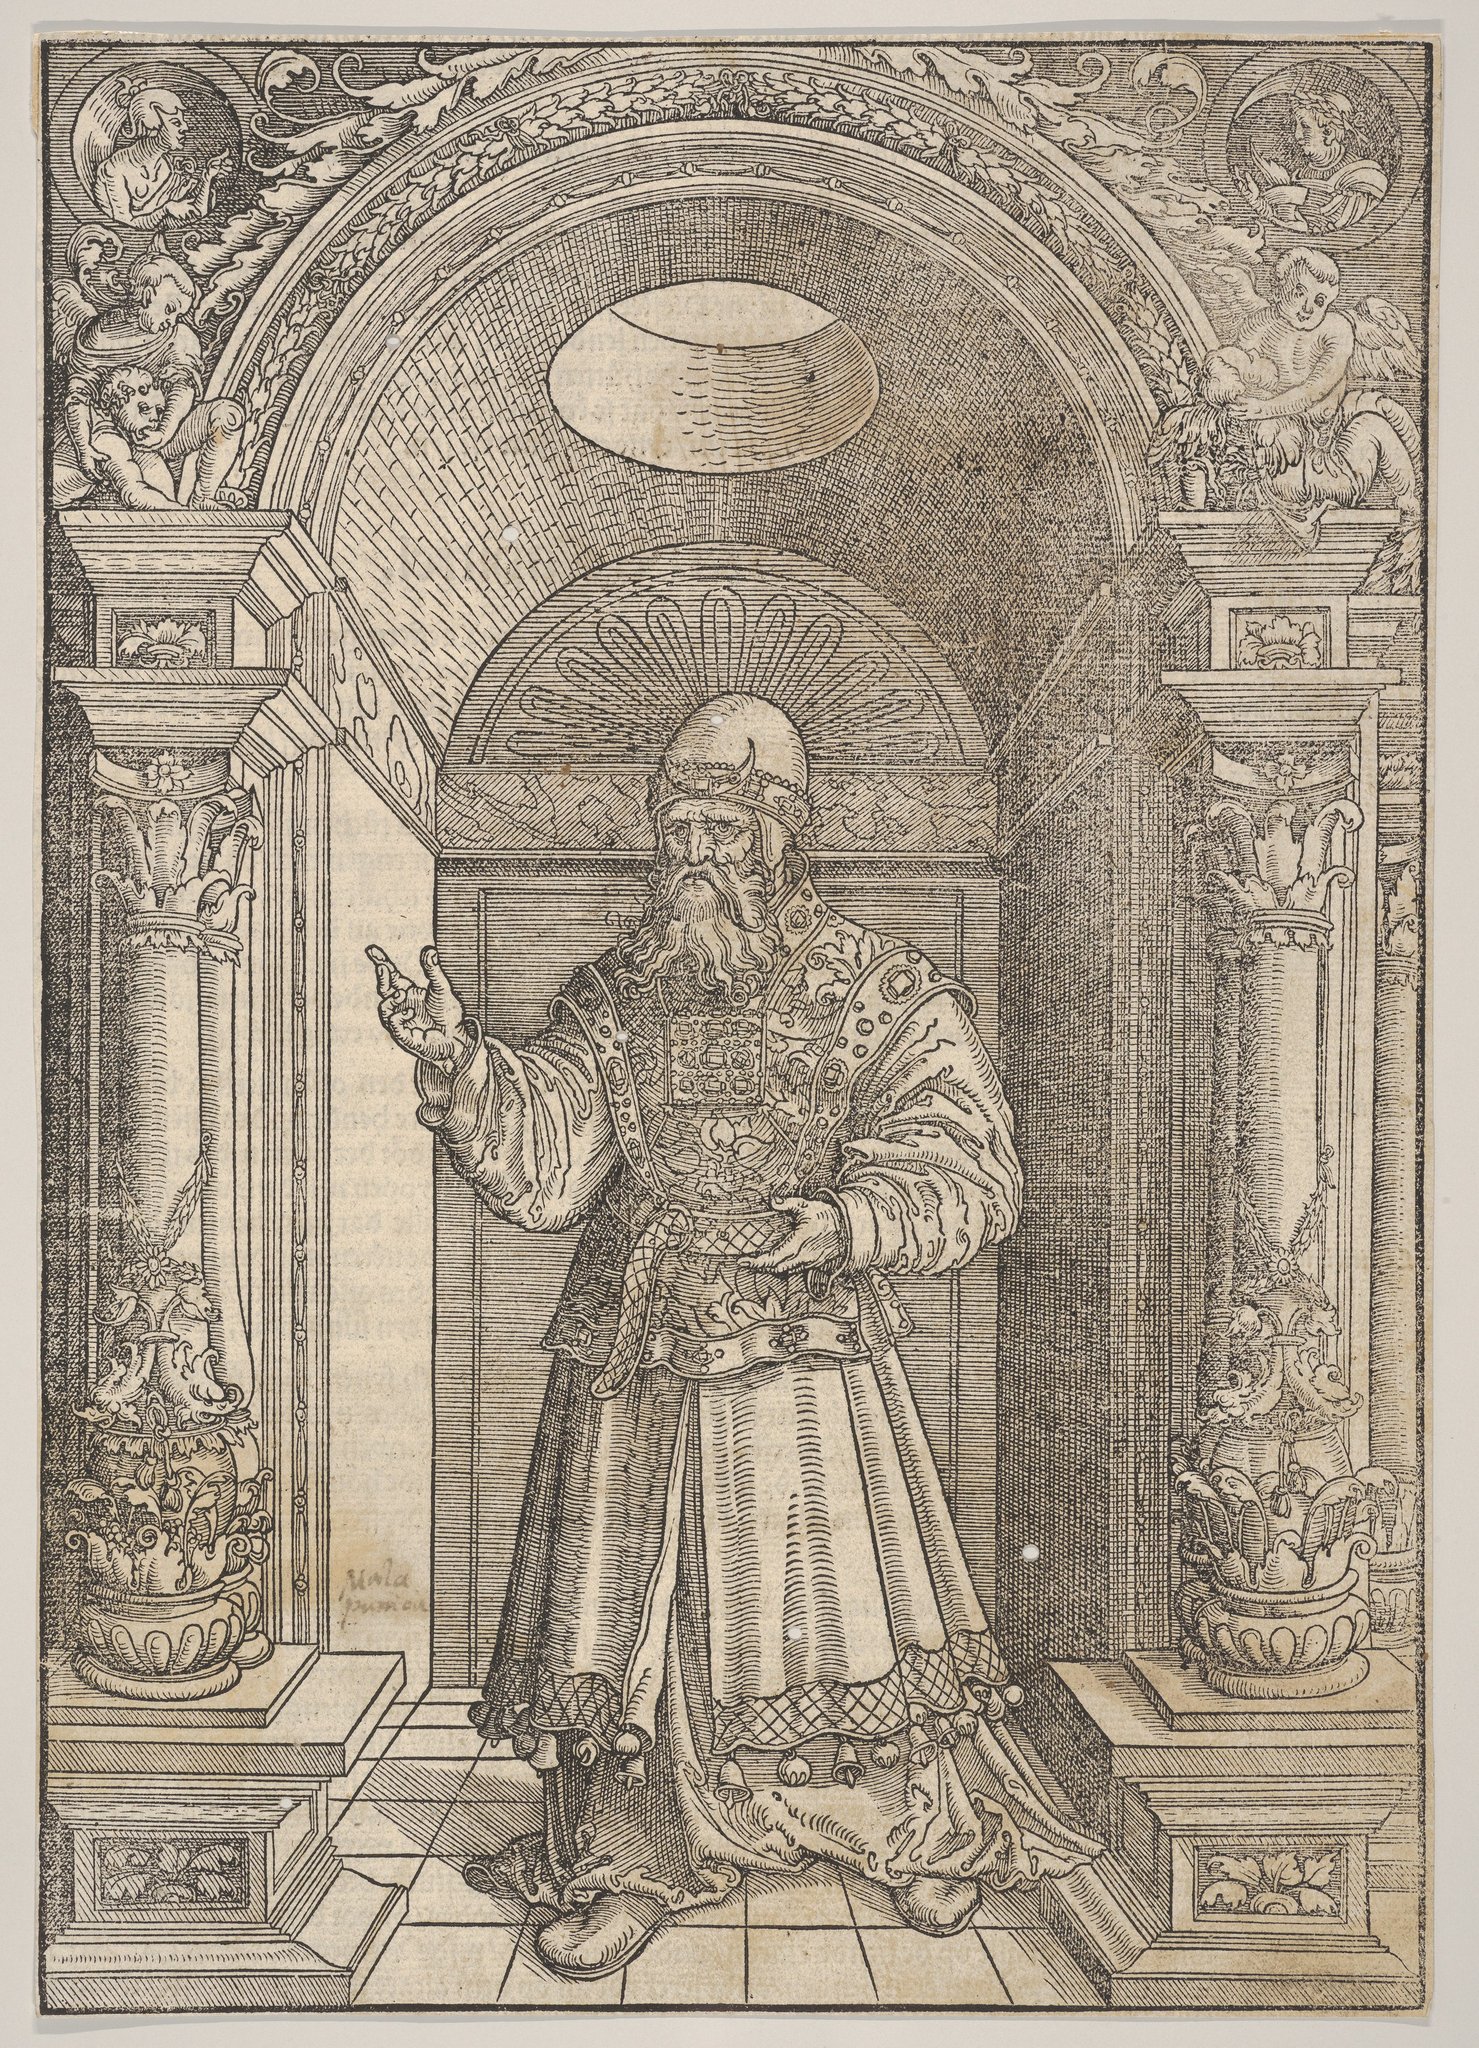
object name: print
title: Aaron, from De Biblie uth der uthlegginge Doctoris Martini Luthers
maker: erhard altdorfer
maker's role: artist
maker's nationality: german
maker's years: 1480-1562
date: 1530-1535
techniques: woodcut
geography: germany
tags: men